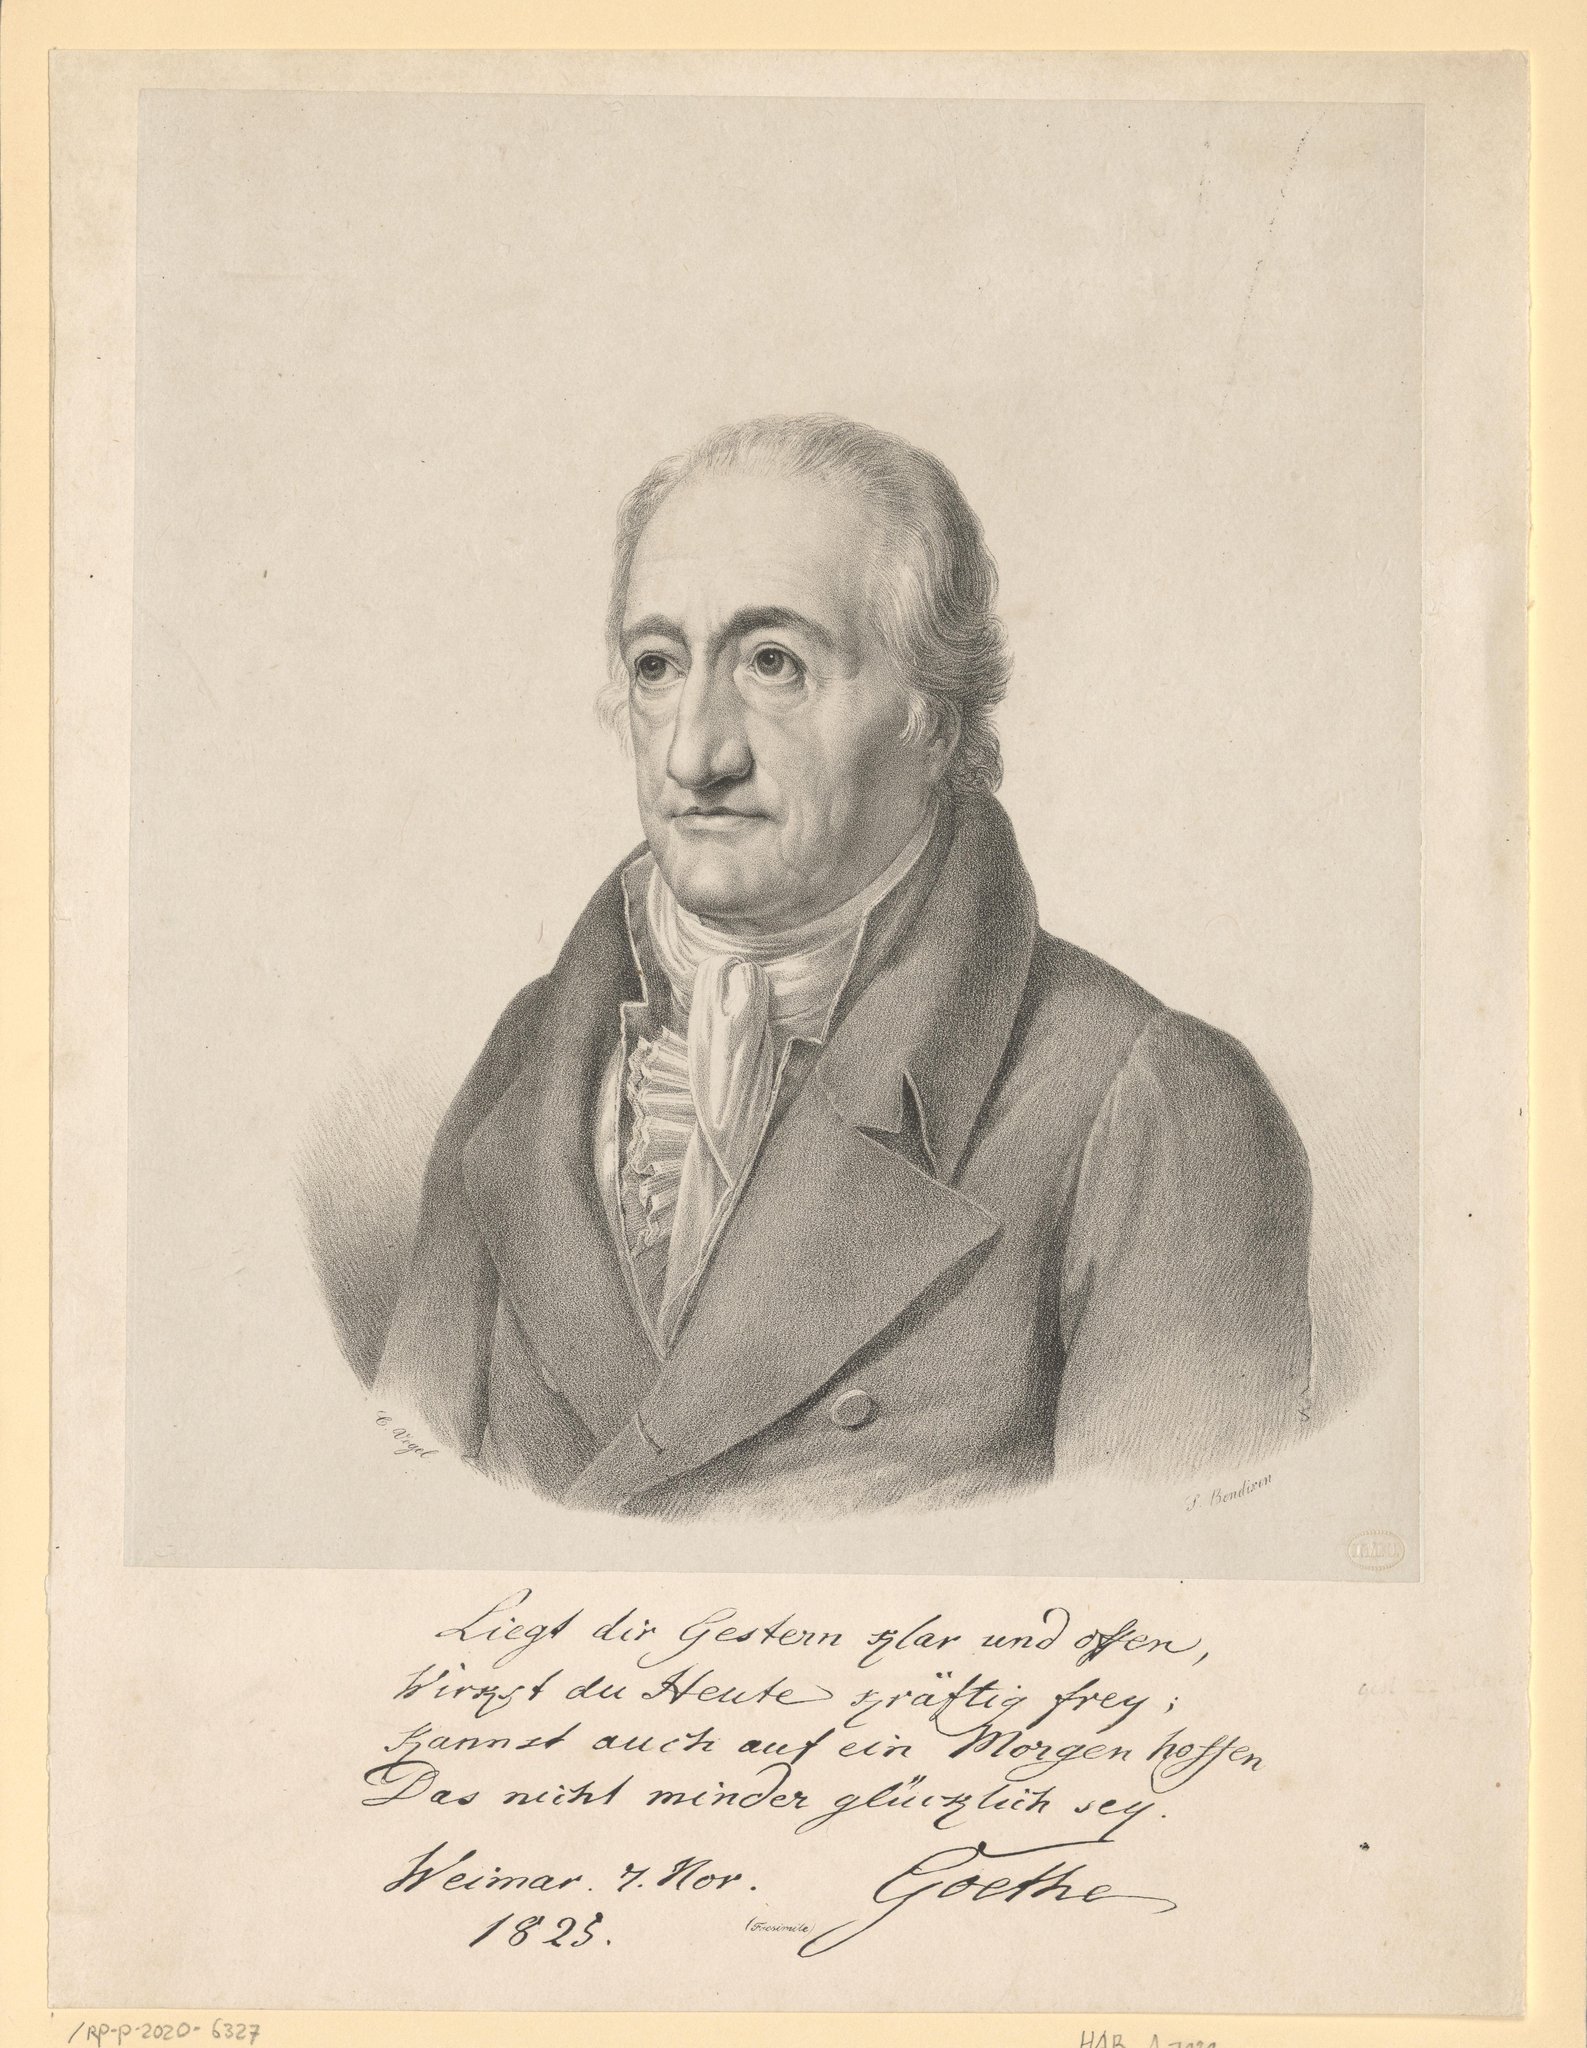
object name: print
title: Portret van van Johann Wolfgang von Goethe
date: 1825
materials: paper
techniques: lithograph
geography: hamburg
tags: draughtsman, johann wolfgang von goethe, historical persons, portrait of a writer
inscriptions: check stamp: ‘IMC’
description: Tekst en facsimile signatuur in de ondermarge.